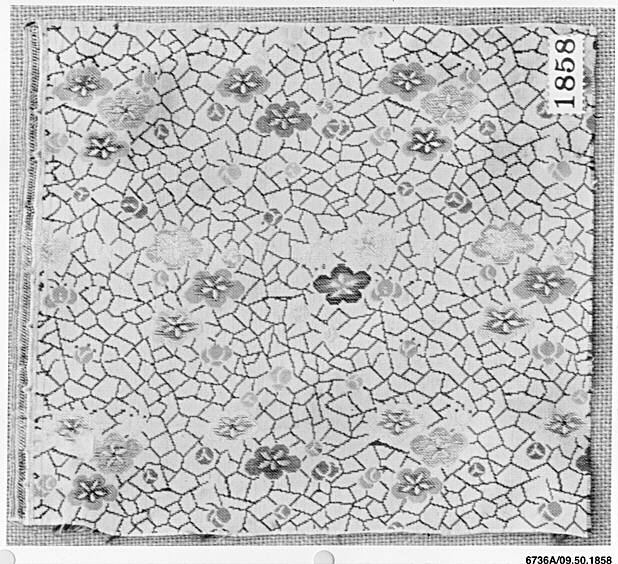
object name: piece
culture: japanese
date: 1615-1868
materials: metal thread, silk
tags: flowers